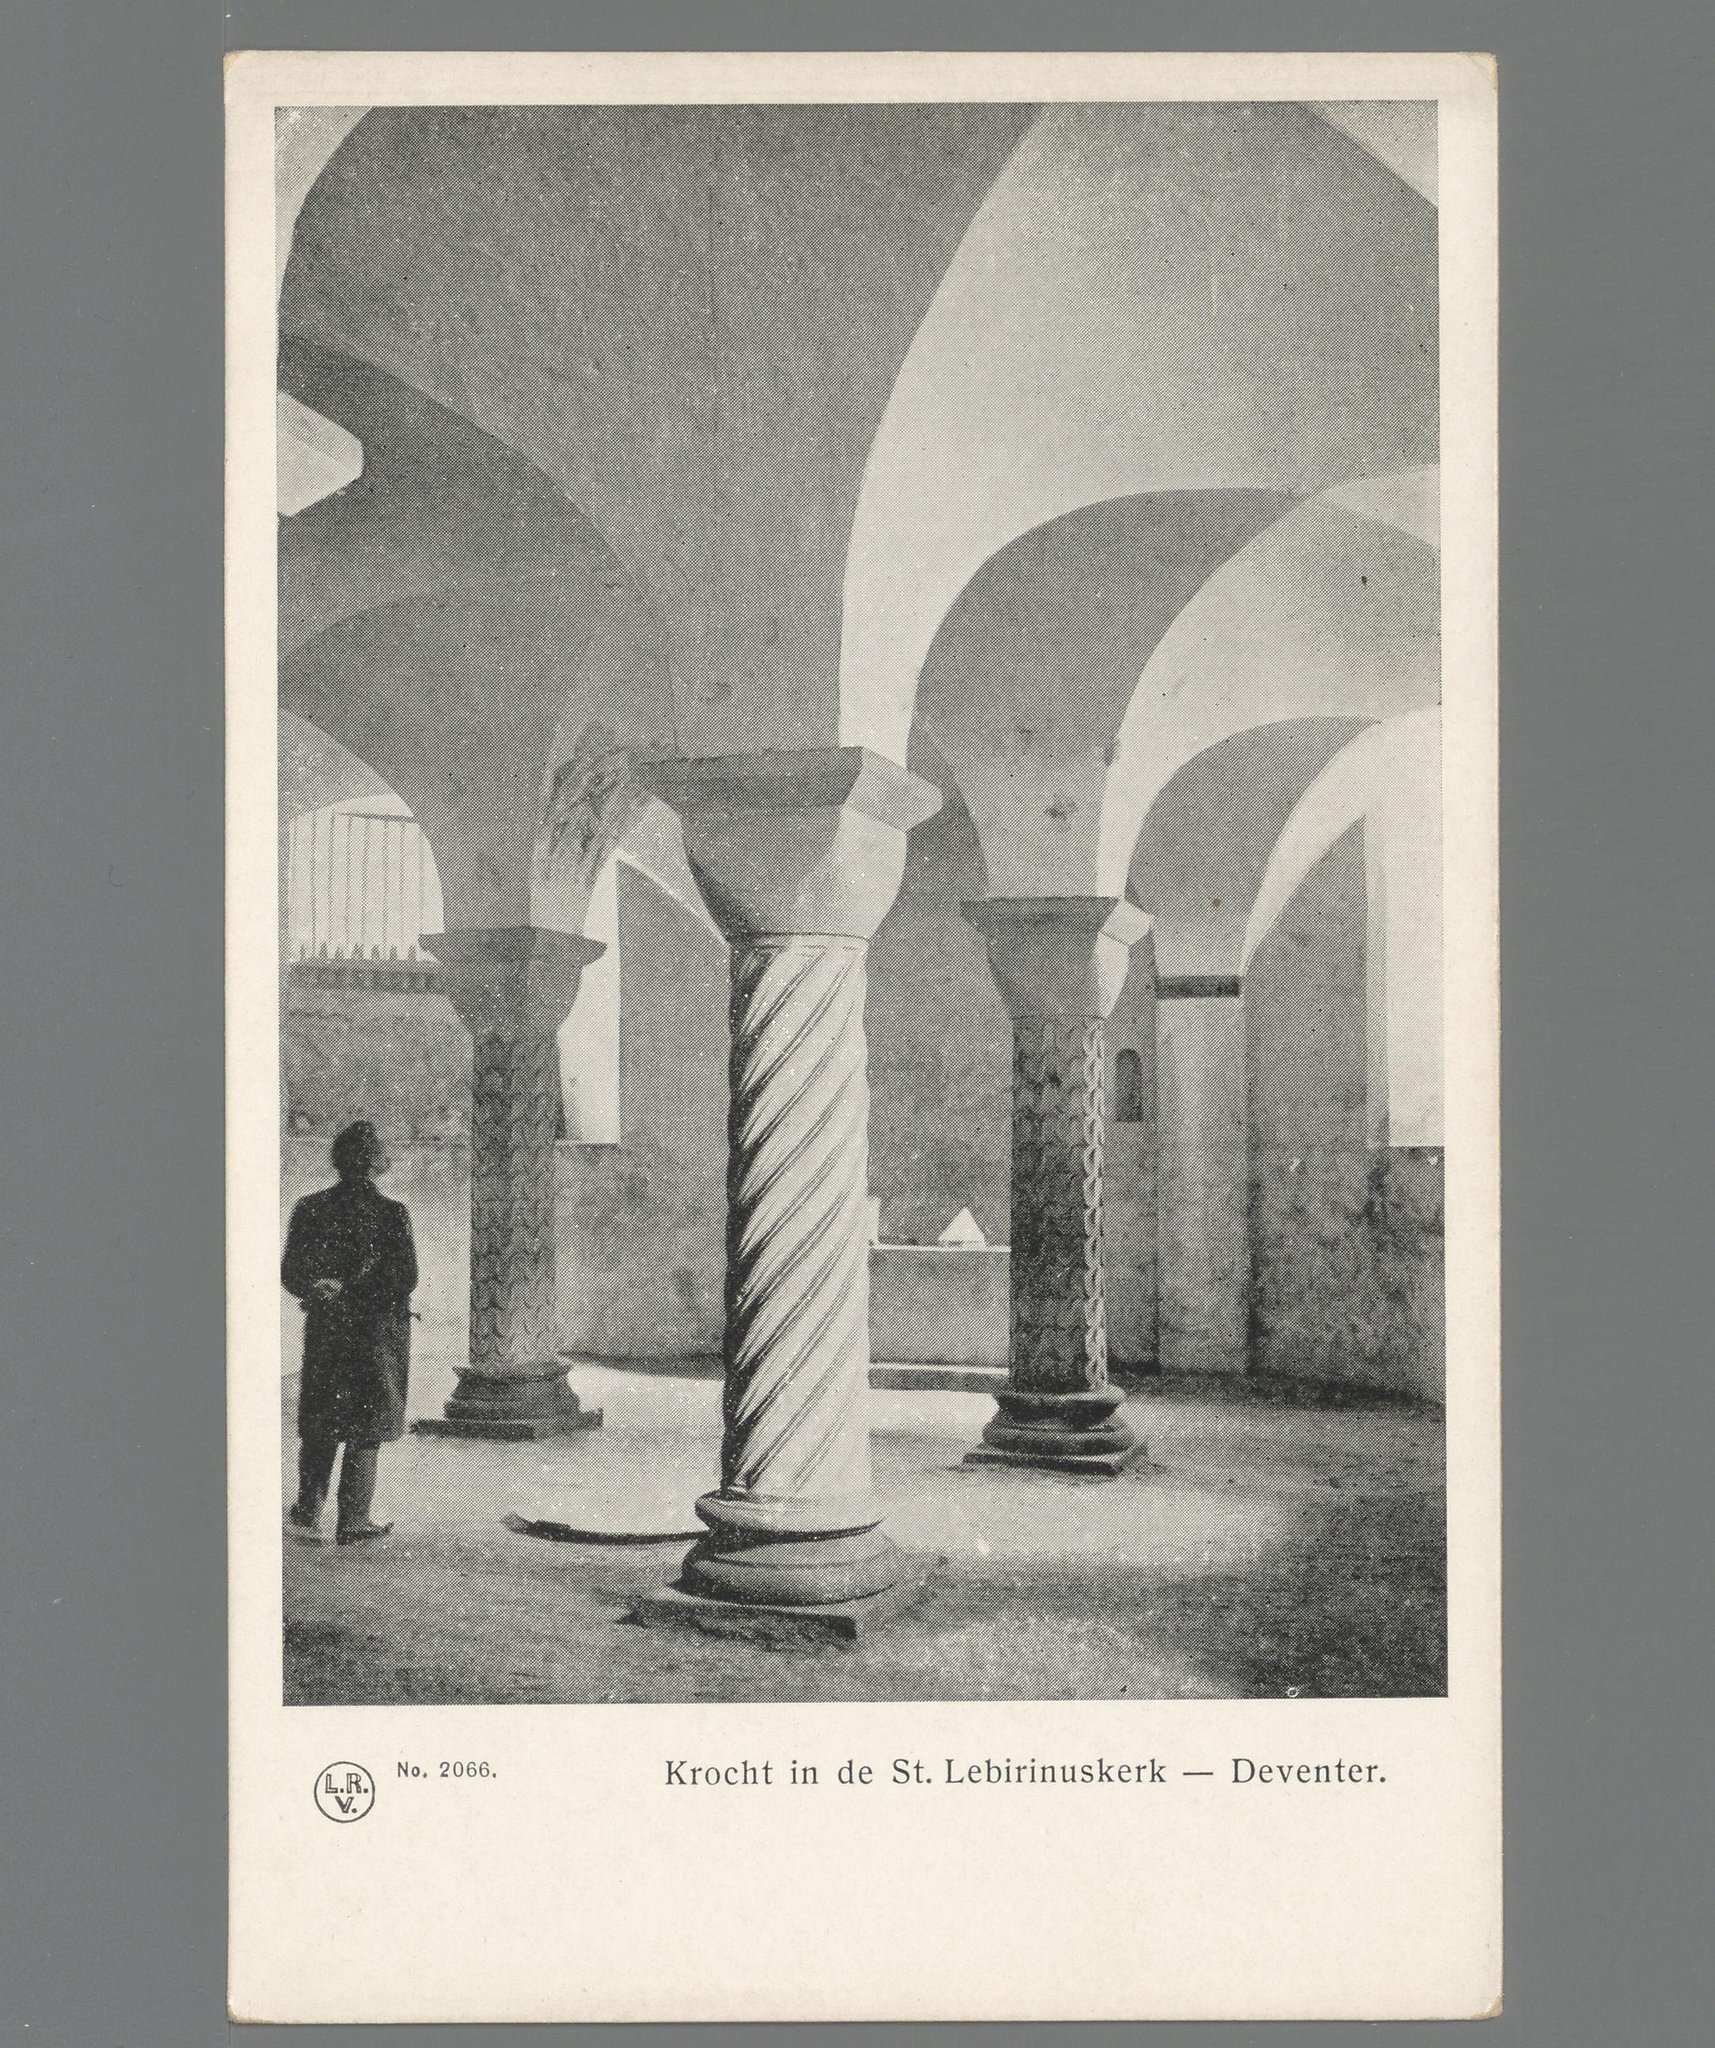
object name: ansichtkaart, prentbriefkaart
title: Krocht in de St. Lebirinuskerk - Deventer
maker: Anonymous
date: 1905-1930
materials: cardboard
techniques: autotype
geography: zwolle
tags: interior of church, vault ~ architecture